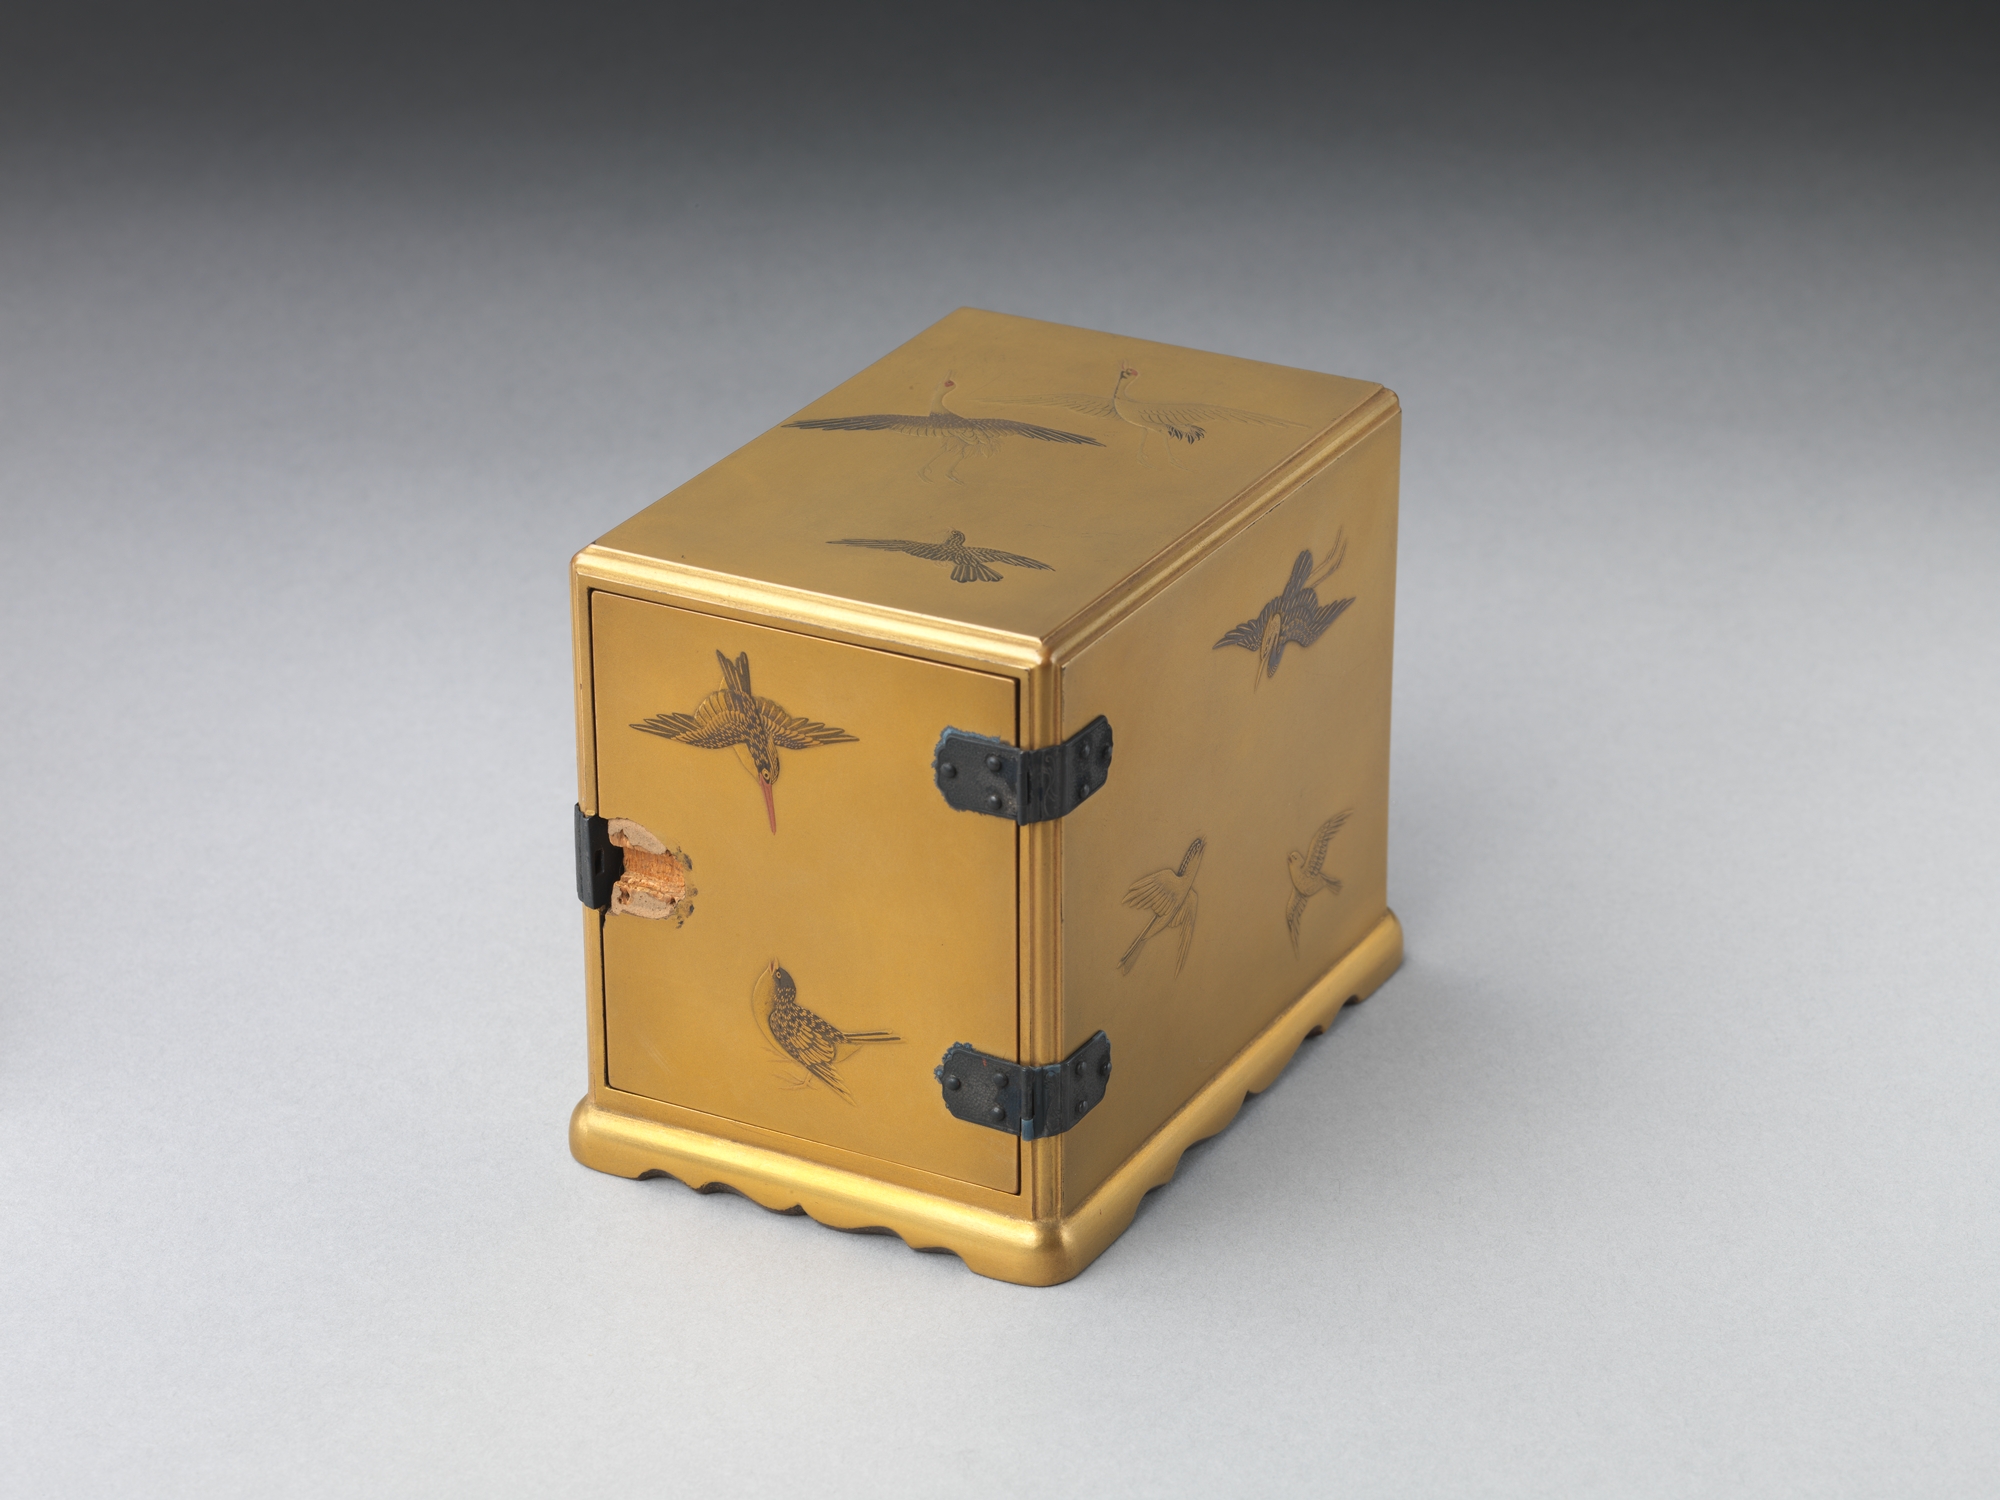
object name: incense cabinet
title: Incense Cabinet with Various Birds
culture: japanese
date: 1801-1900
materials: gold, lacquer, silver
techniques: hiramakie, maki-e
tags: birds,cabinets